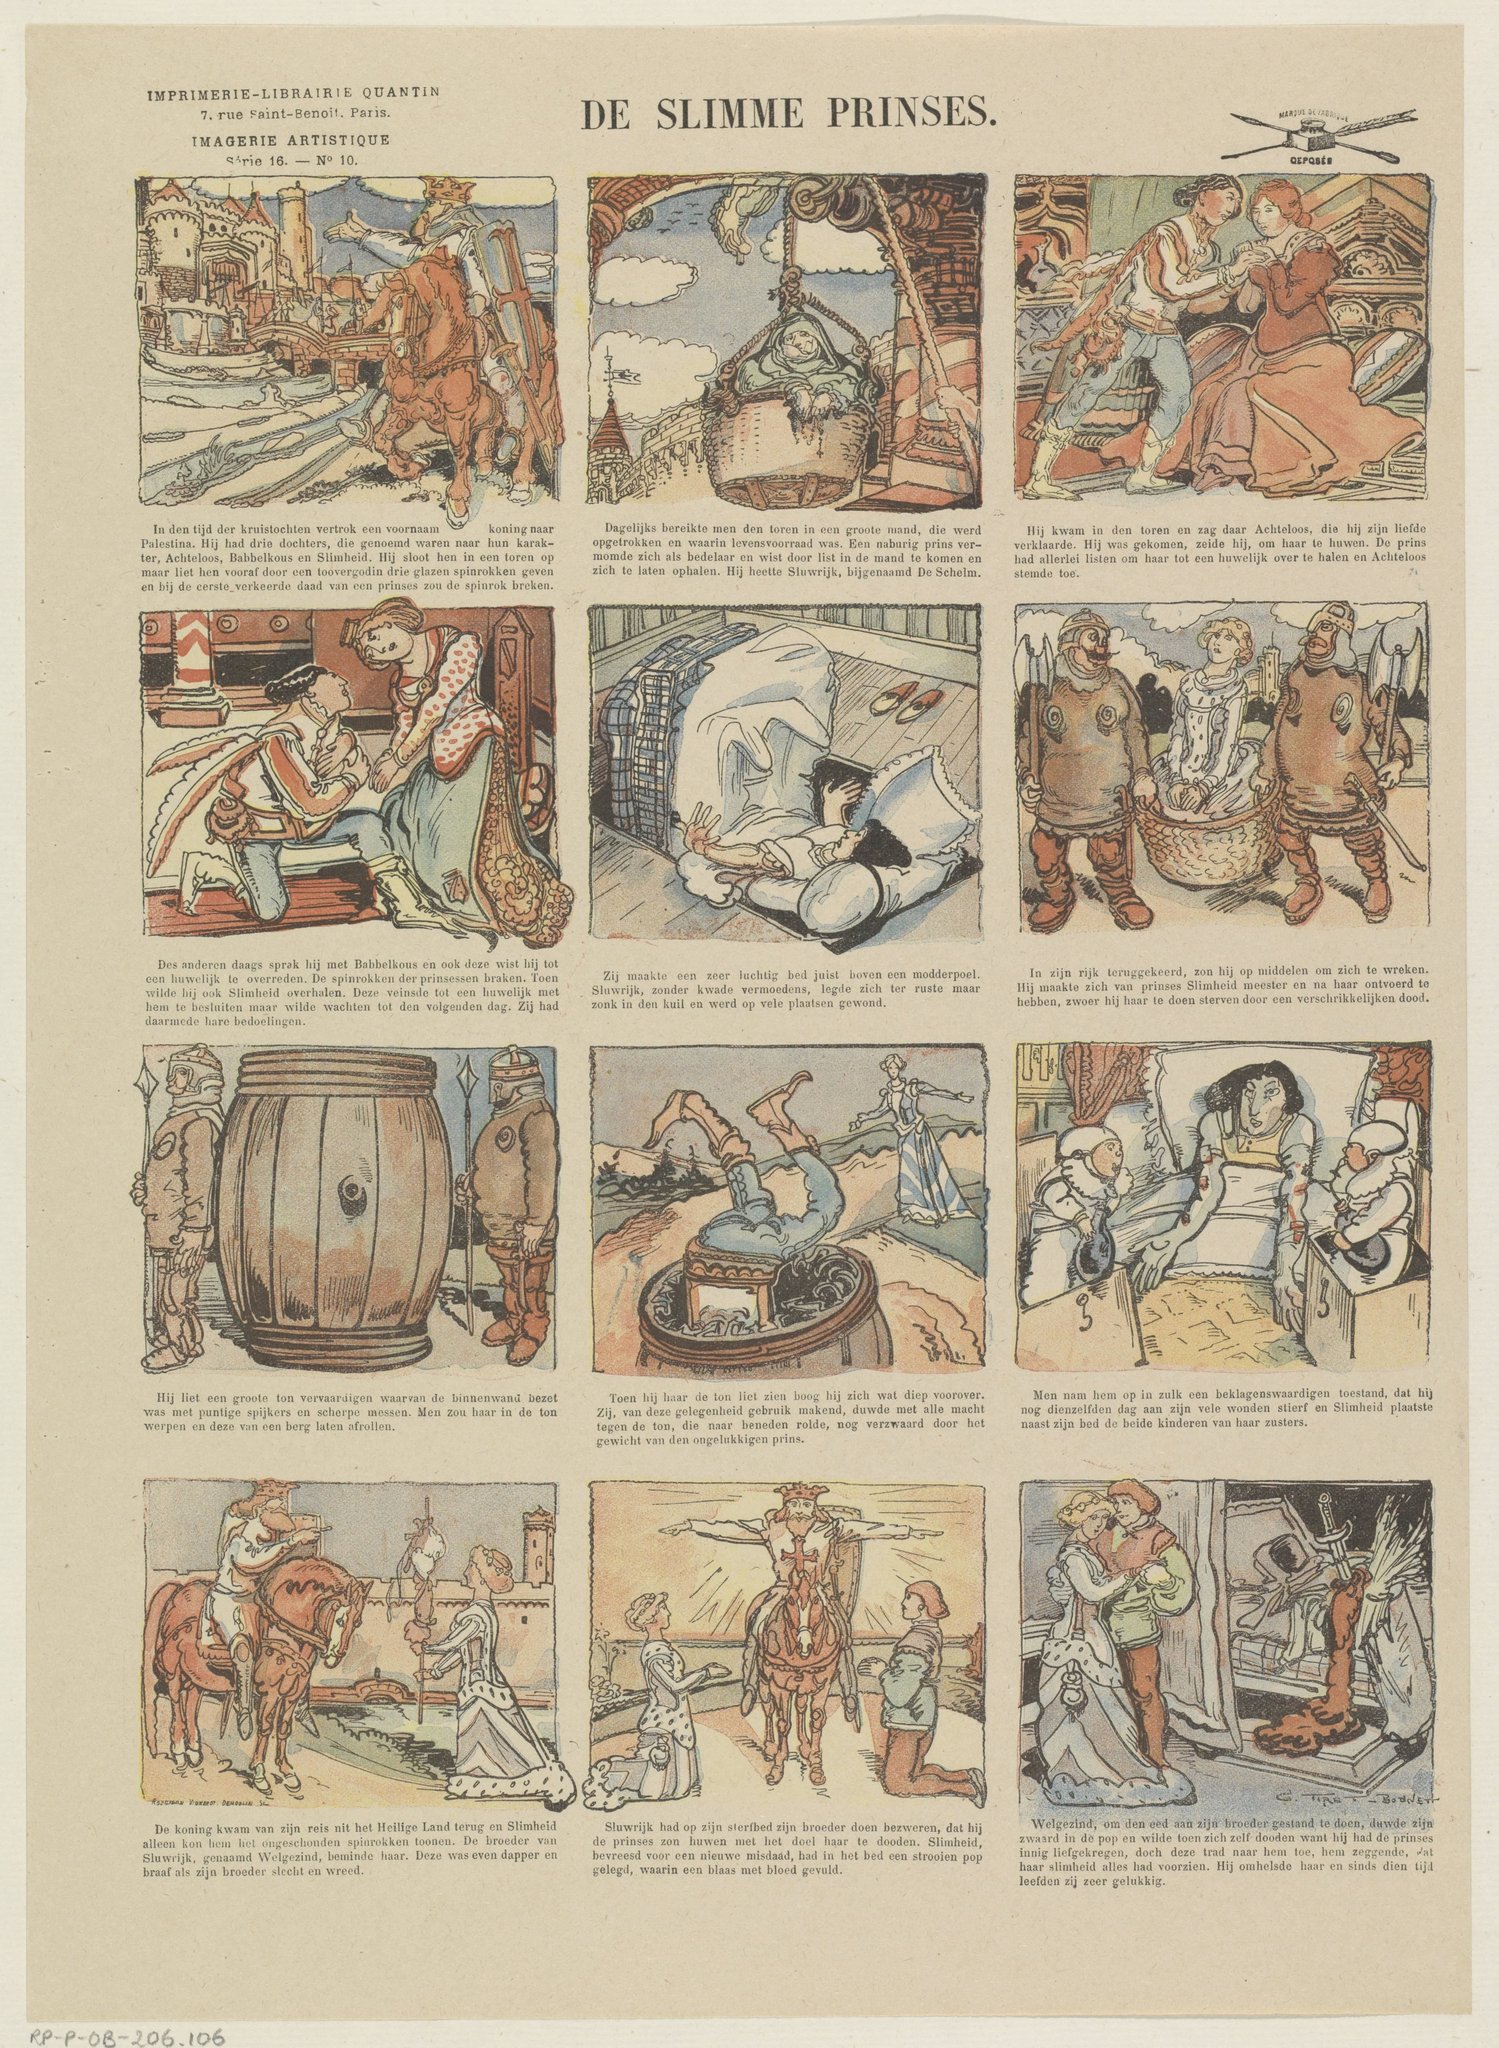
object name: print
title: De slimme prinses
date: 1876-1890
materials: paper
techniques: lithograph, letterpress printing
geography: paris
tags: prince, princess, tales and fairy tales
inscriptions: collector's mark: Lugt 2760, : ‘marque de fabrique / deposée’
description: Blad met 12 voorstellingen uit het sprookje van de slimme prinses. Onder elke afbeelding een onderschrift. Genummerd linksboven: Série 16. - No. 10.